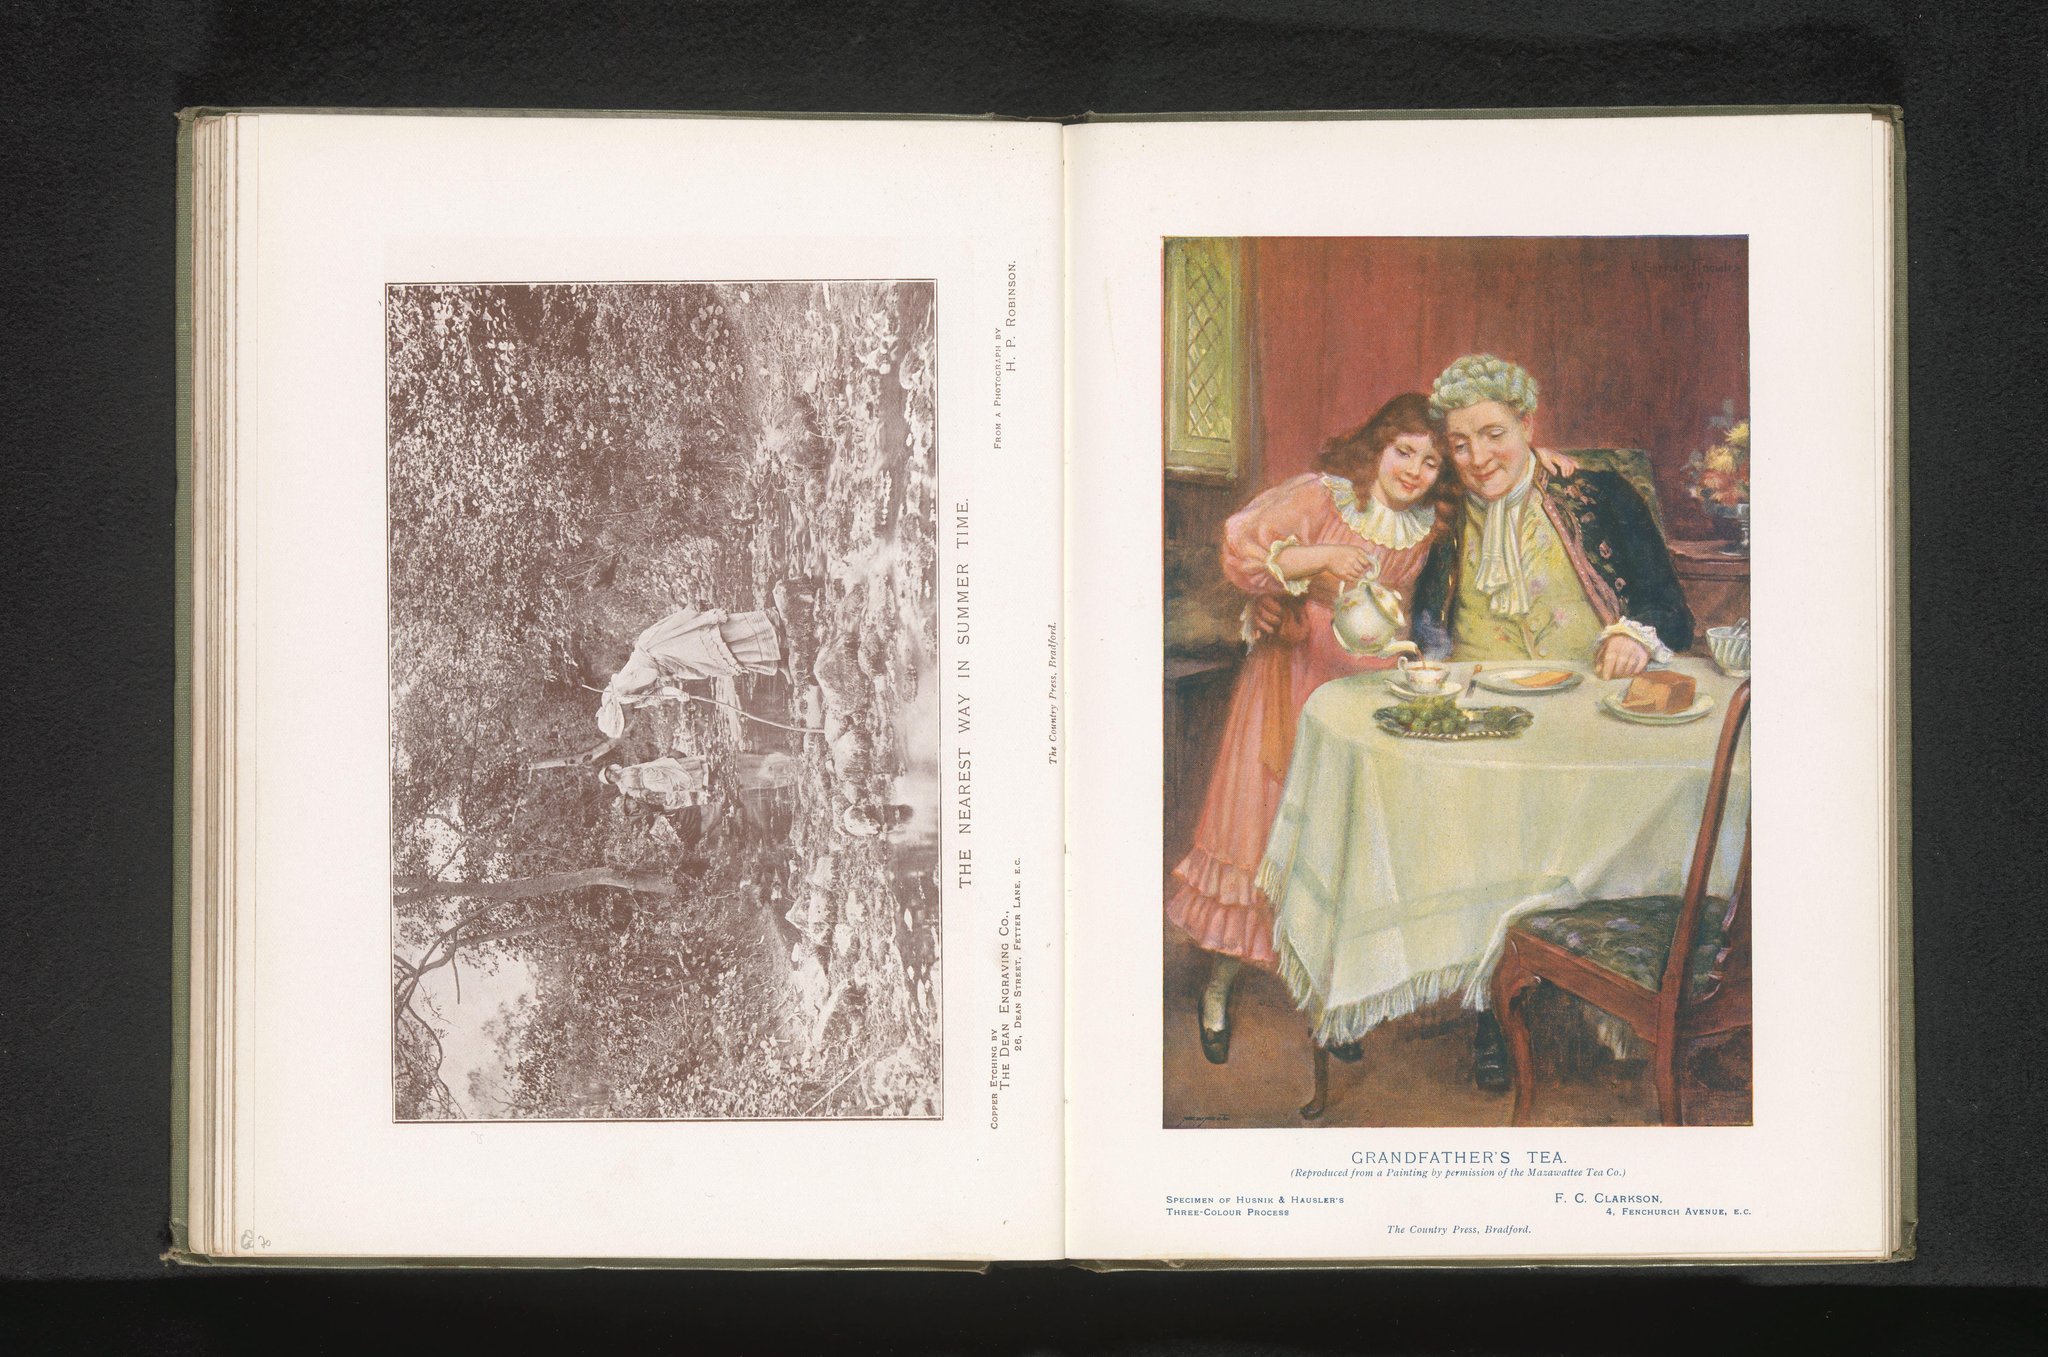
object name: page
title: The nearest way in summer time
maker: henry peach robinson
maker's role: fotograaf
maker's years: 1830-1901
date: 1893-1898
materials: paper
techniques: autotype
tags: adult woman, river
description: Prent op vierde ongenummerde pagina na pagina 88.